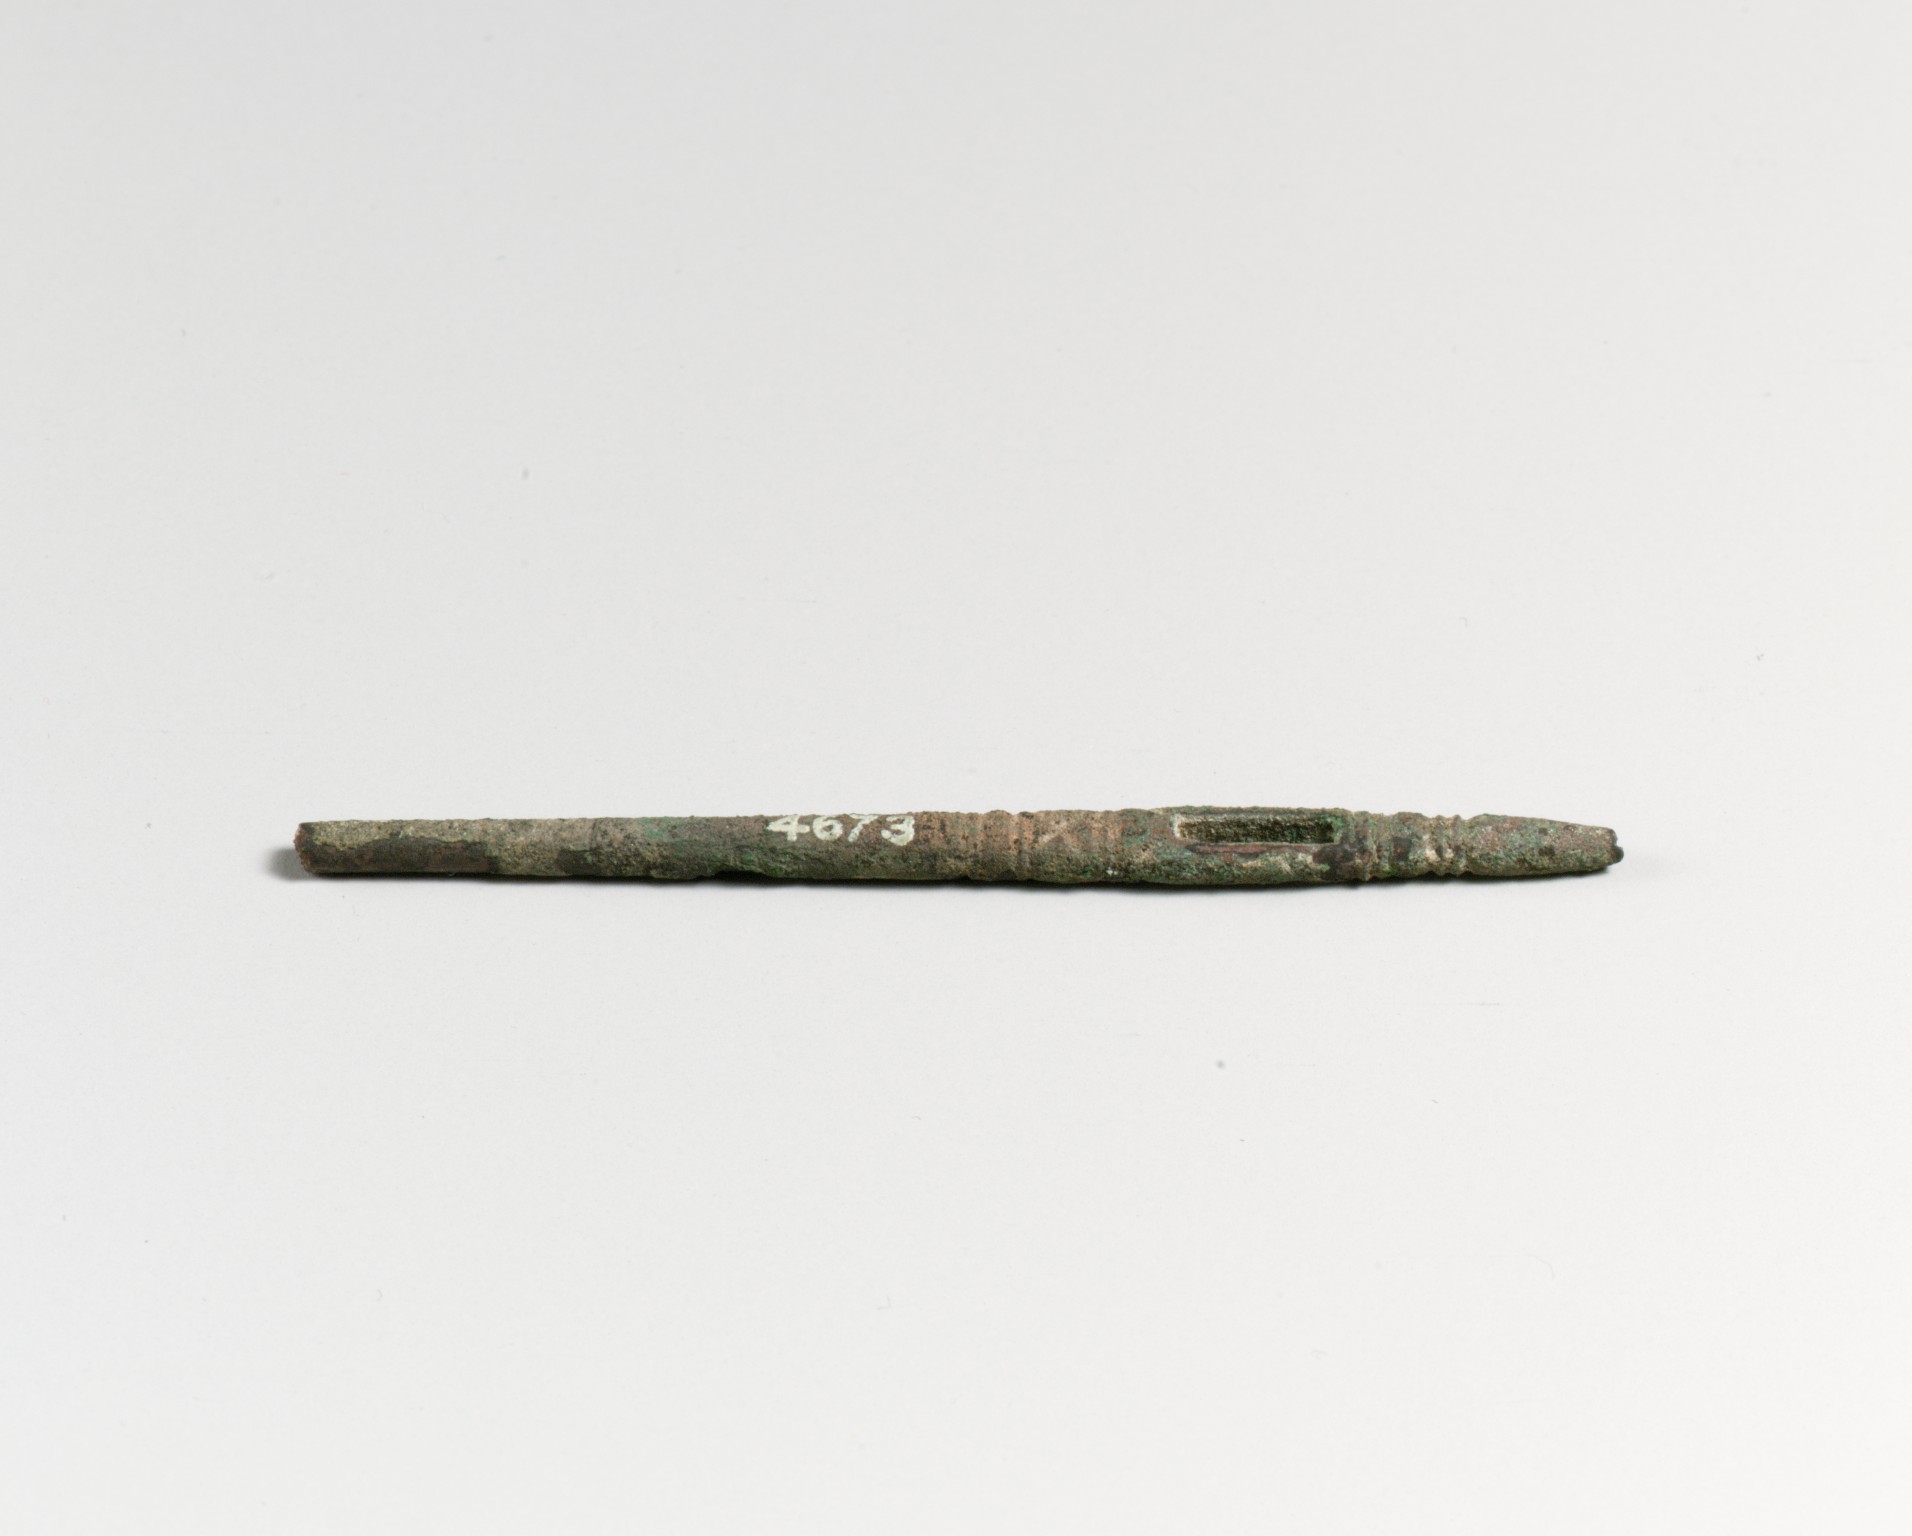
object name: needle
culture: cypriot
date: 3900 BCE-100 CE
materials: bronze